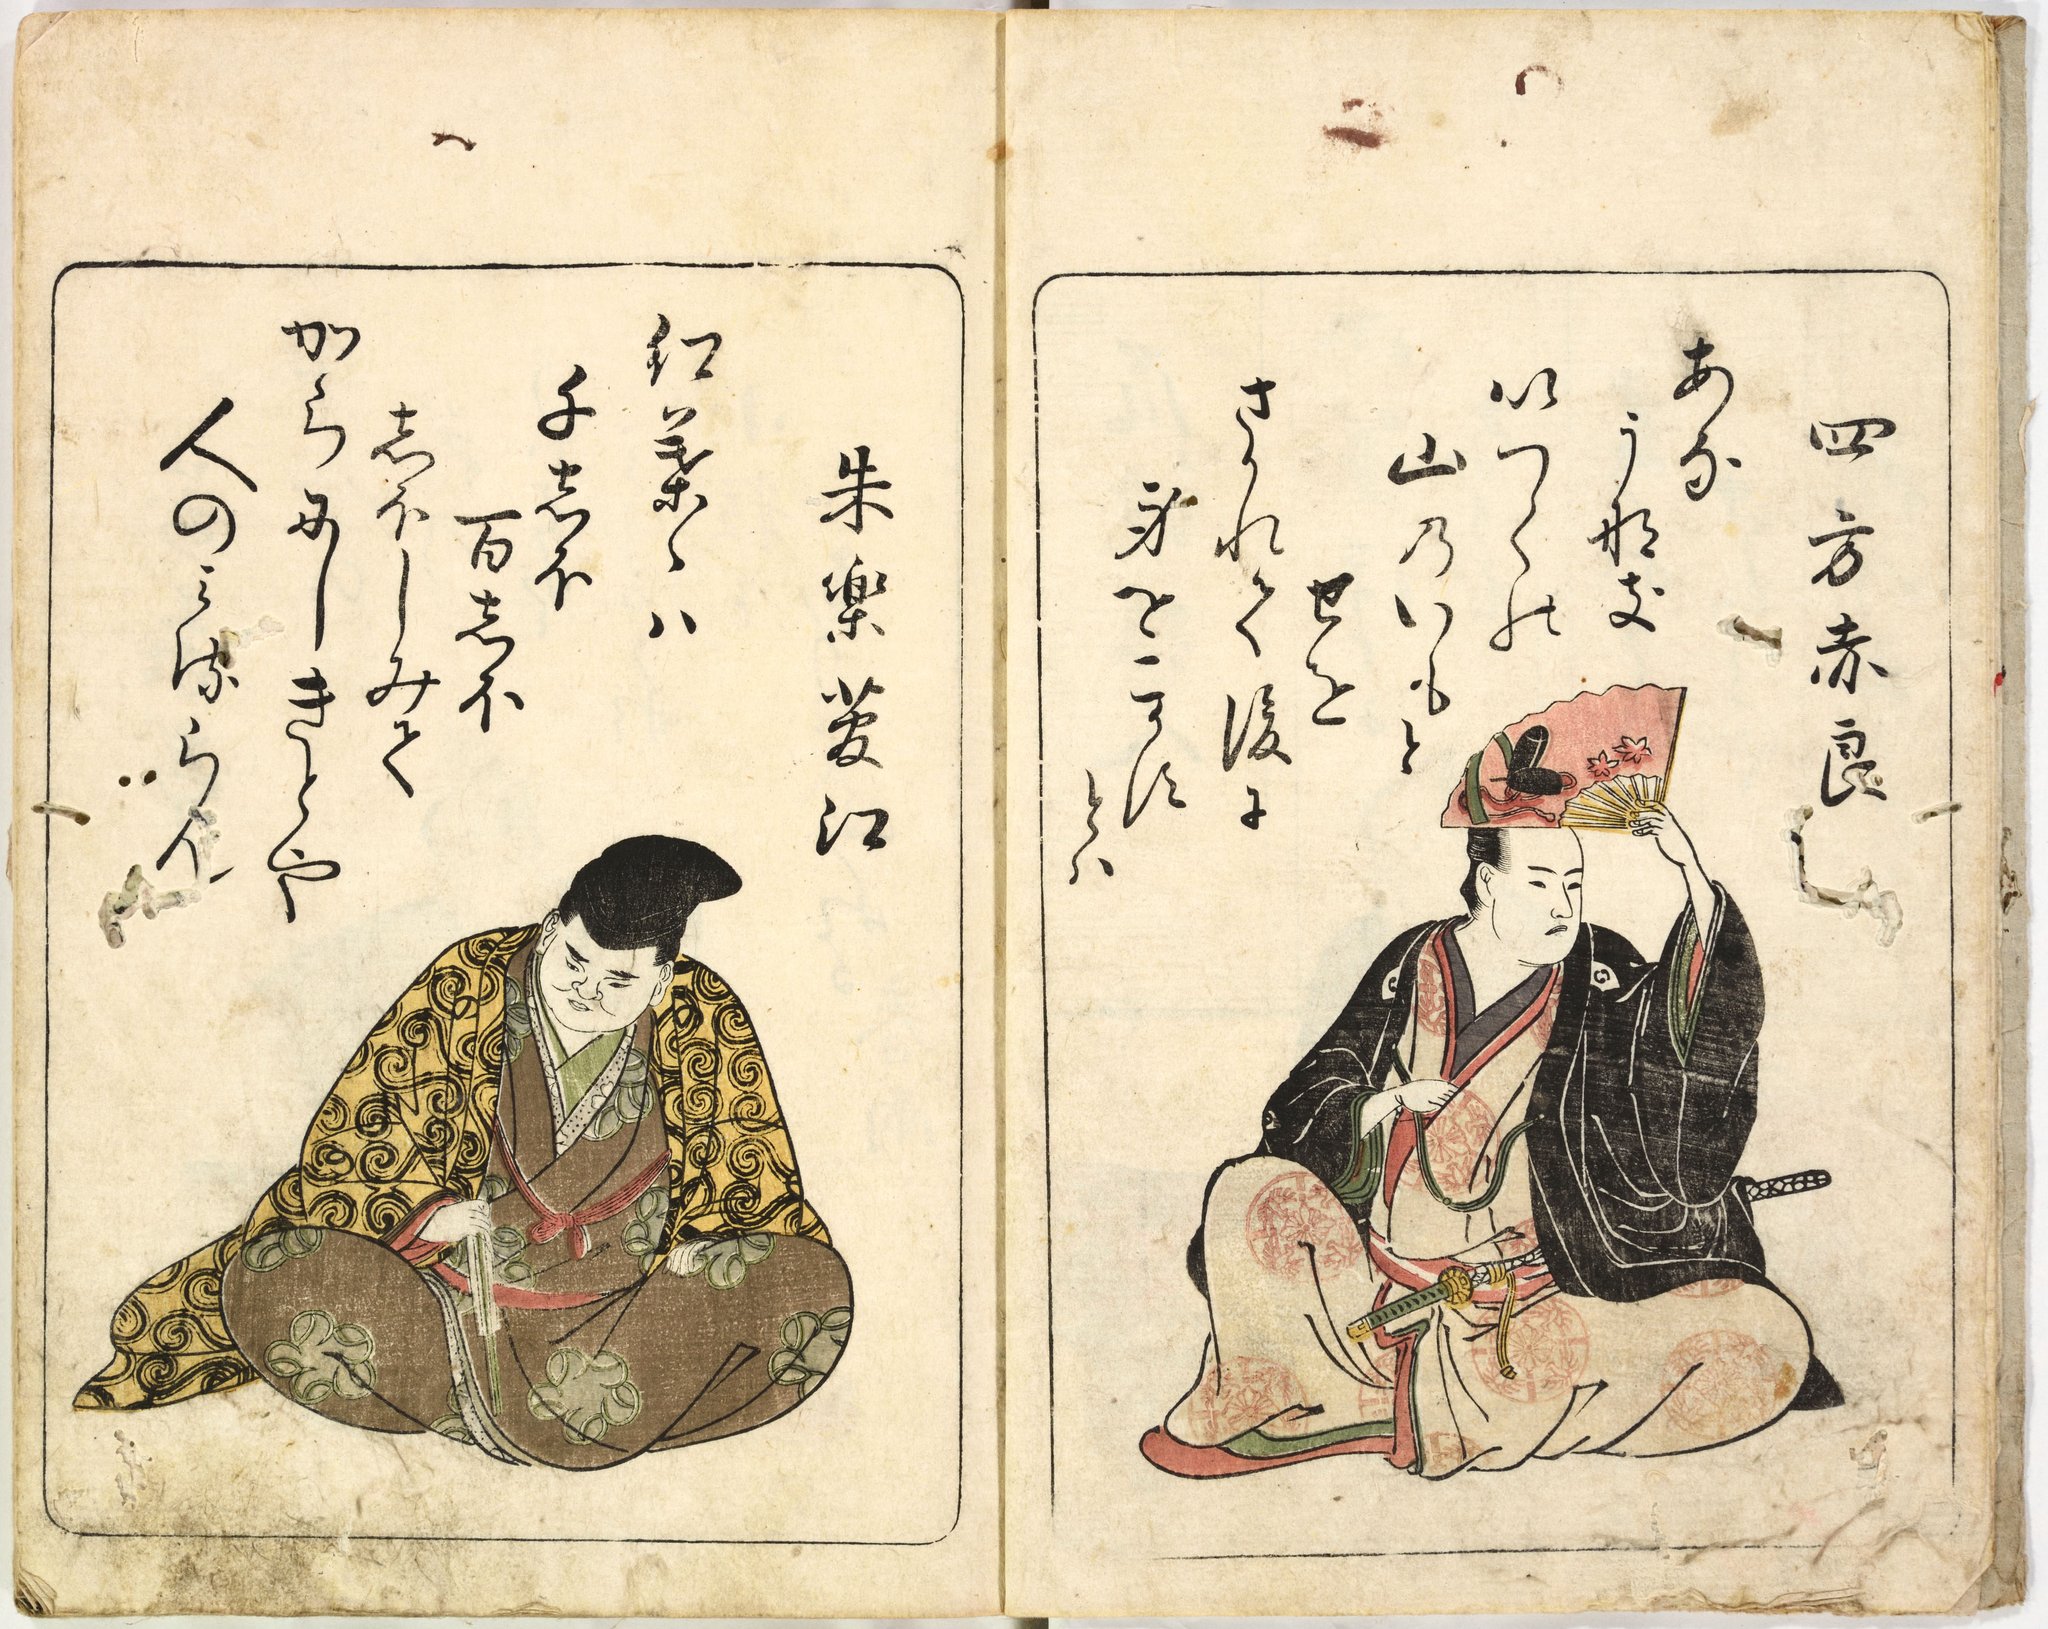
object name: illustrated book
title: A New Series of Fifty Poets' Stanzas of the Temmei Period; A Bookcase of Humorous Poems in the Azuma (i.e. Edo) Style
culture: japanese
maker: kitao masanobu (santō kyōden)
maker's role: artist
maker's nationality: japanese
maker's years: 1761-1816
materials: ink, paper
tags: poetry,men,women